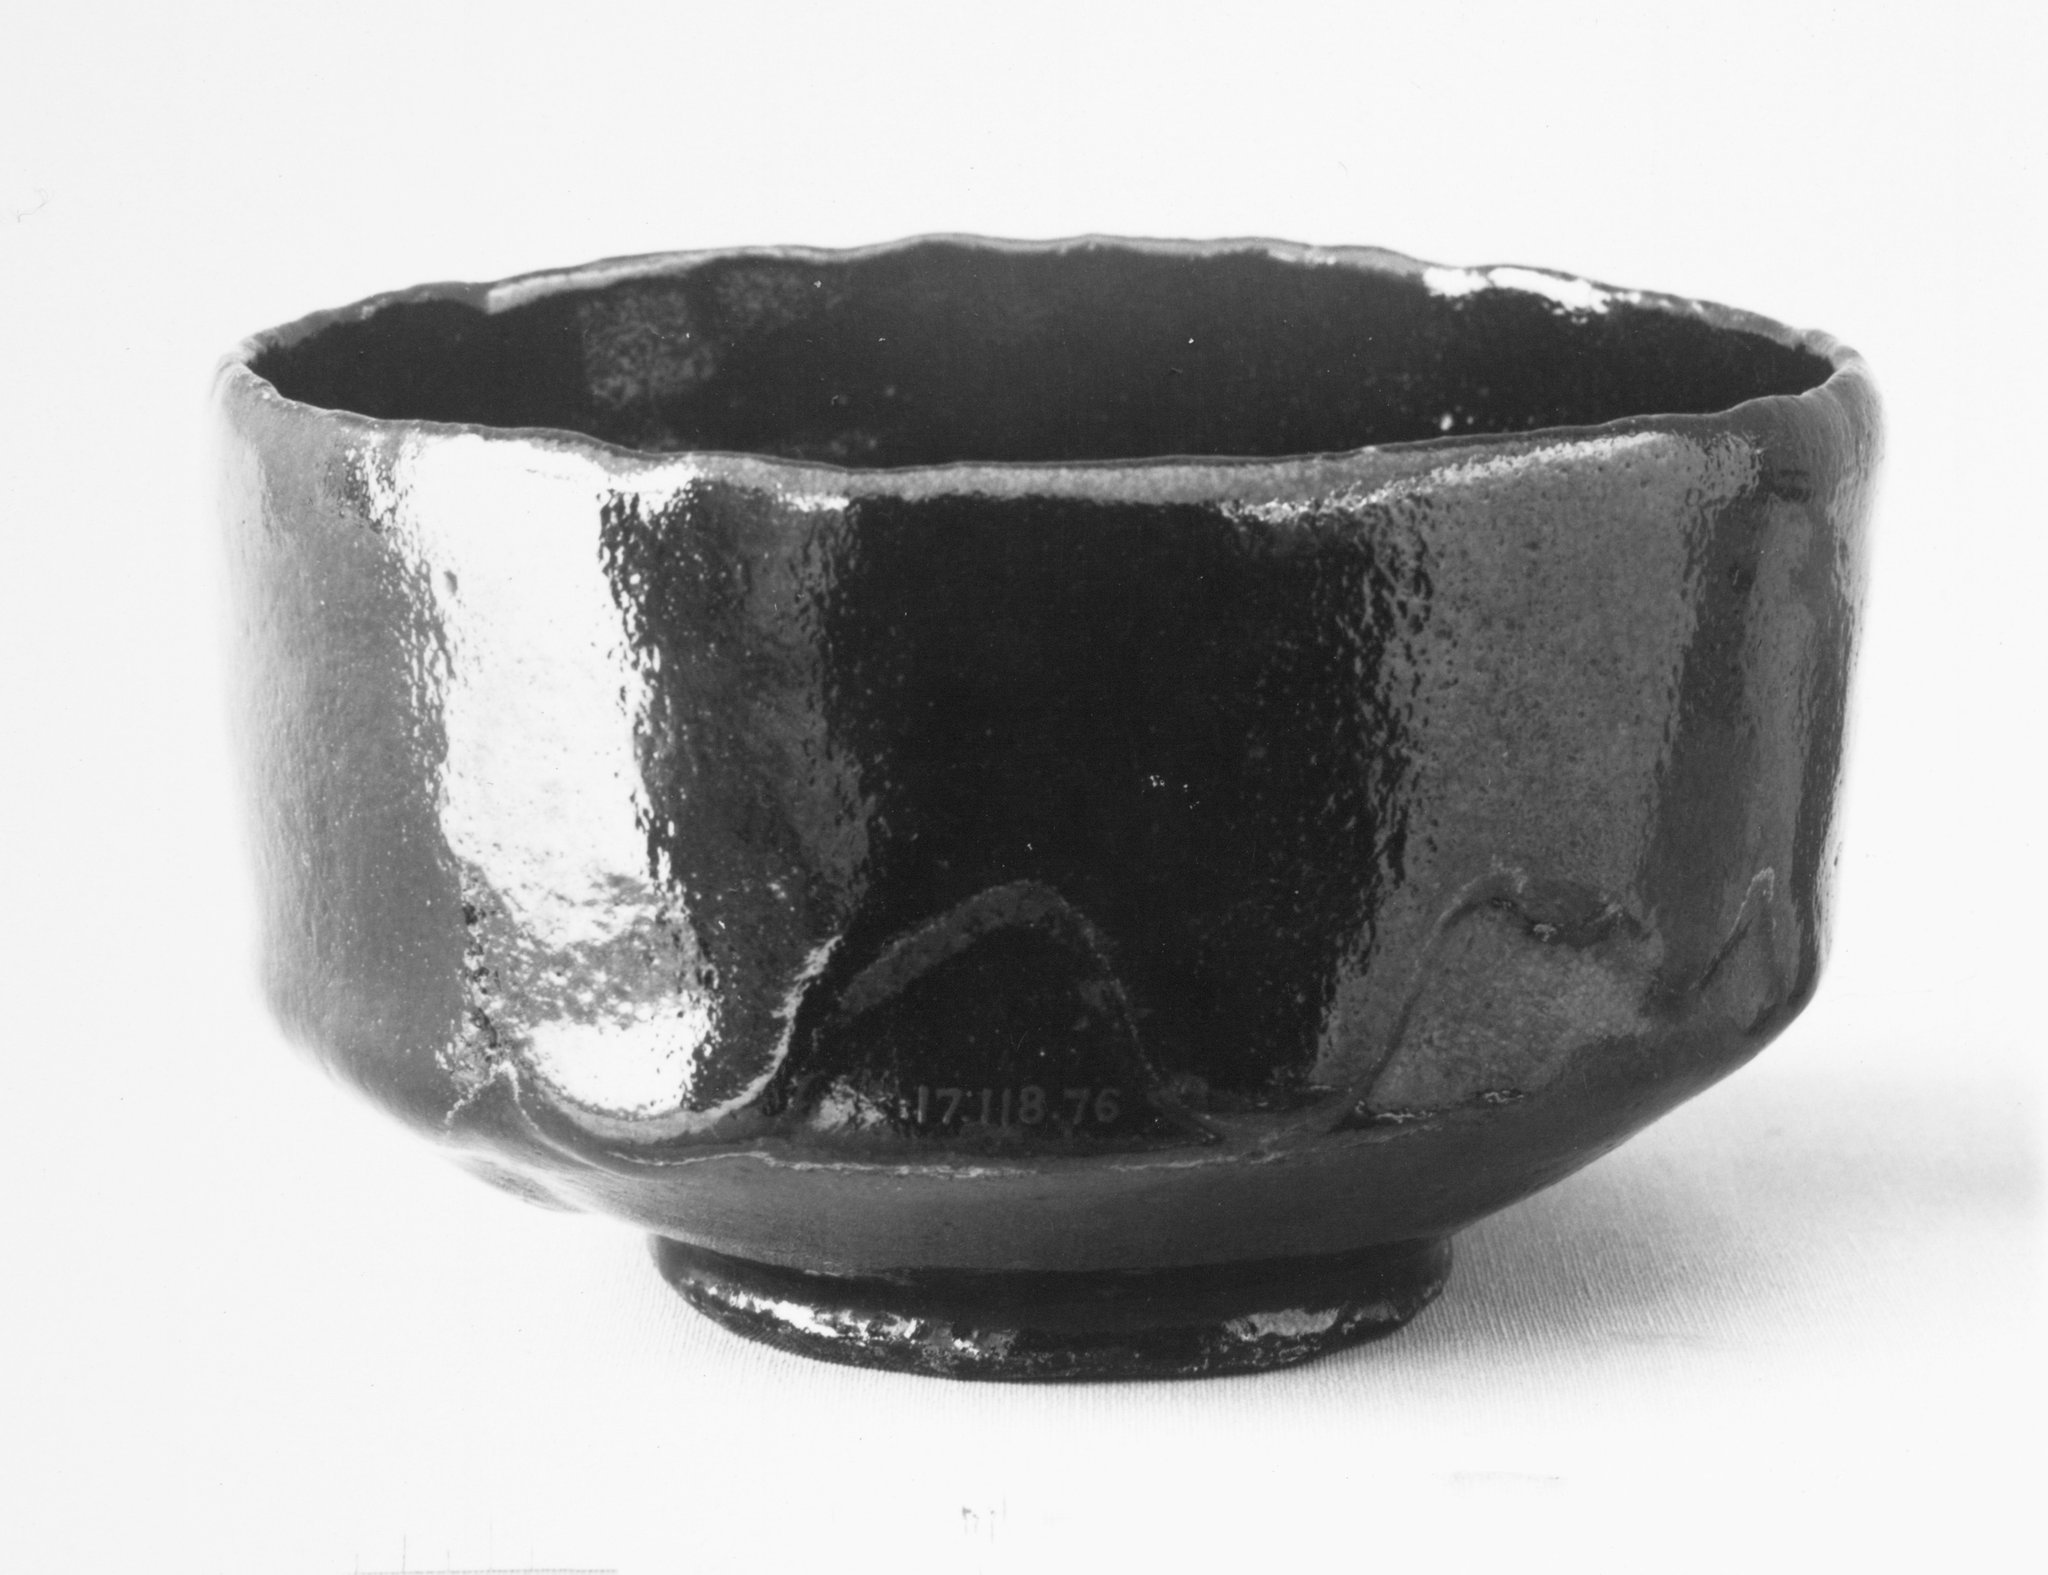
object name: teabowl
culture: japanese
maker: raku donyu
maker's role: artist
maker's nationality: japanese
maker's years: 1556-1656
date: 1650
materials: clay, glaze